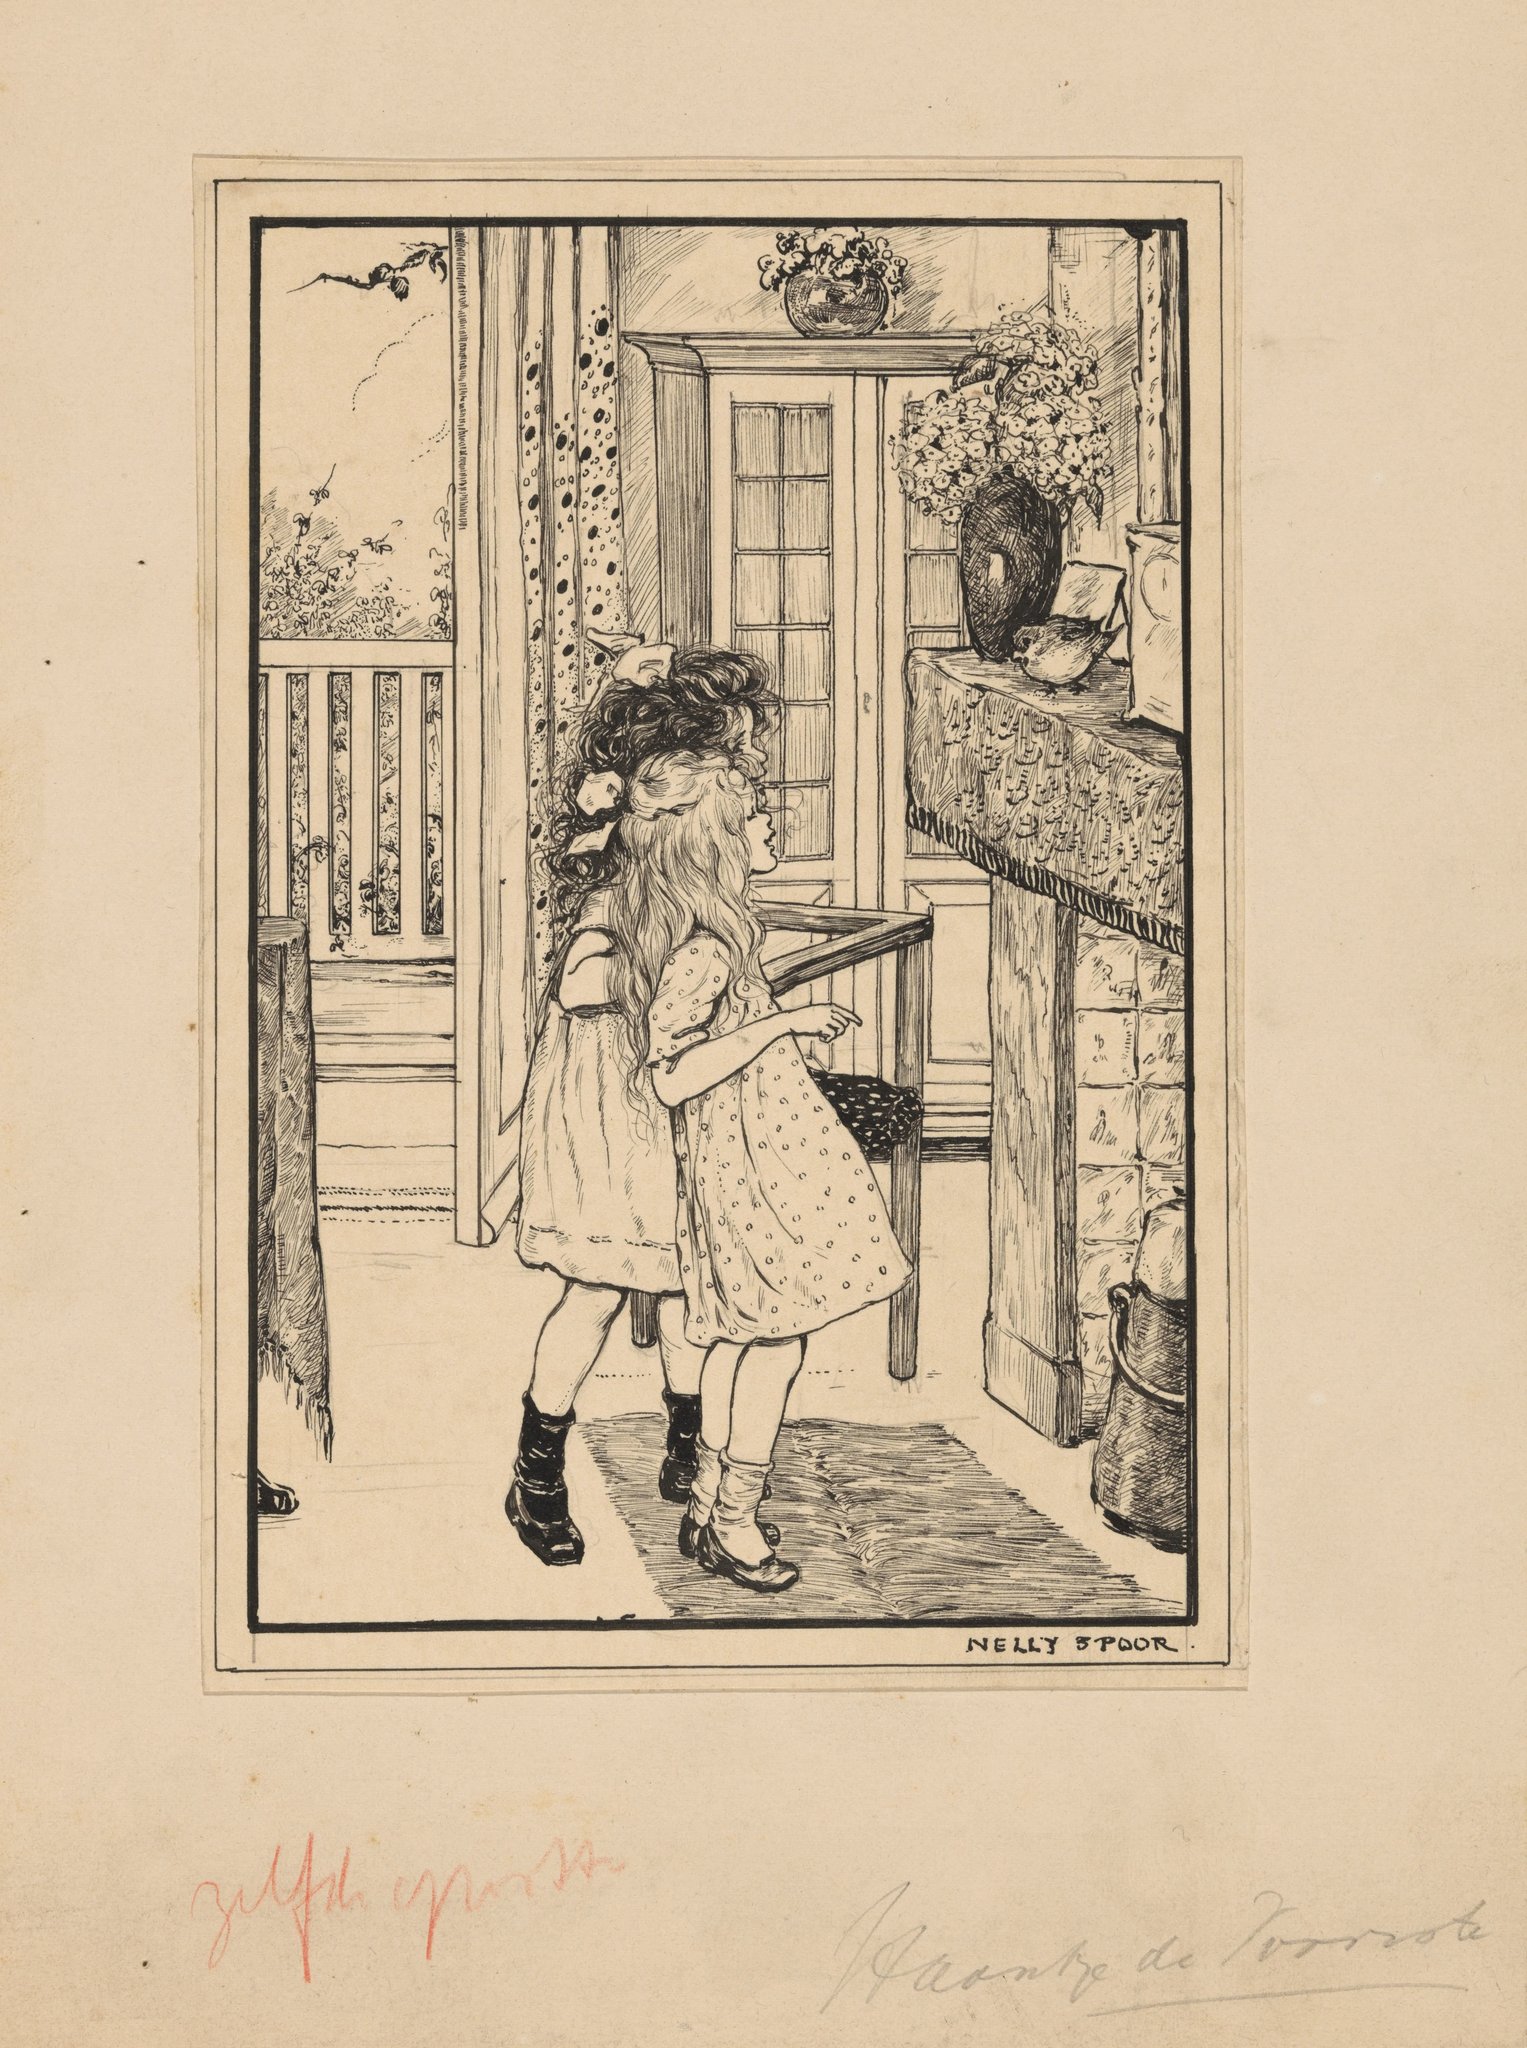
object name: boekillustratie ontwerp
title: Twee meisjes kijkend naar een vogel op een schouw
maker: nelly spoor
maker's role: draughtsman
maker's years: 1885-1950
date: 1895-1950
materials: cardboard, ink, paper, pencil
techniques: pen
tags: open door, birds, girl (child between toddler and youth), chimney-piece, mantelpiece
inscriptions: :, signature: ‘NELLY SPOOR .’, annotation: ‘Haantje de Voorste’, collector's mark: Lugt 2228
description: Twee meisjes staan naast elkaar in een interieur voor een schouw. Ze kijken naar een vogel die tussen een vaas met bloemen en een klok op de schoorsteenmantel zit. De deur van de kamer staat open.